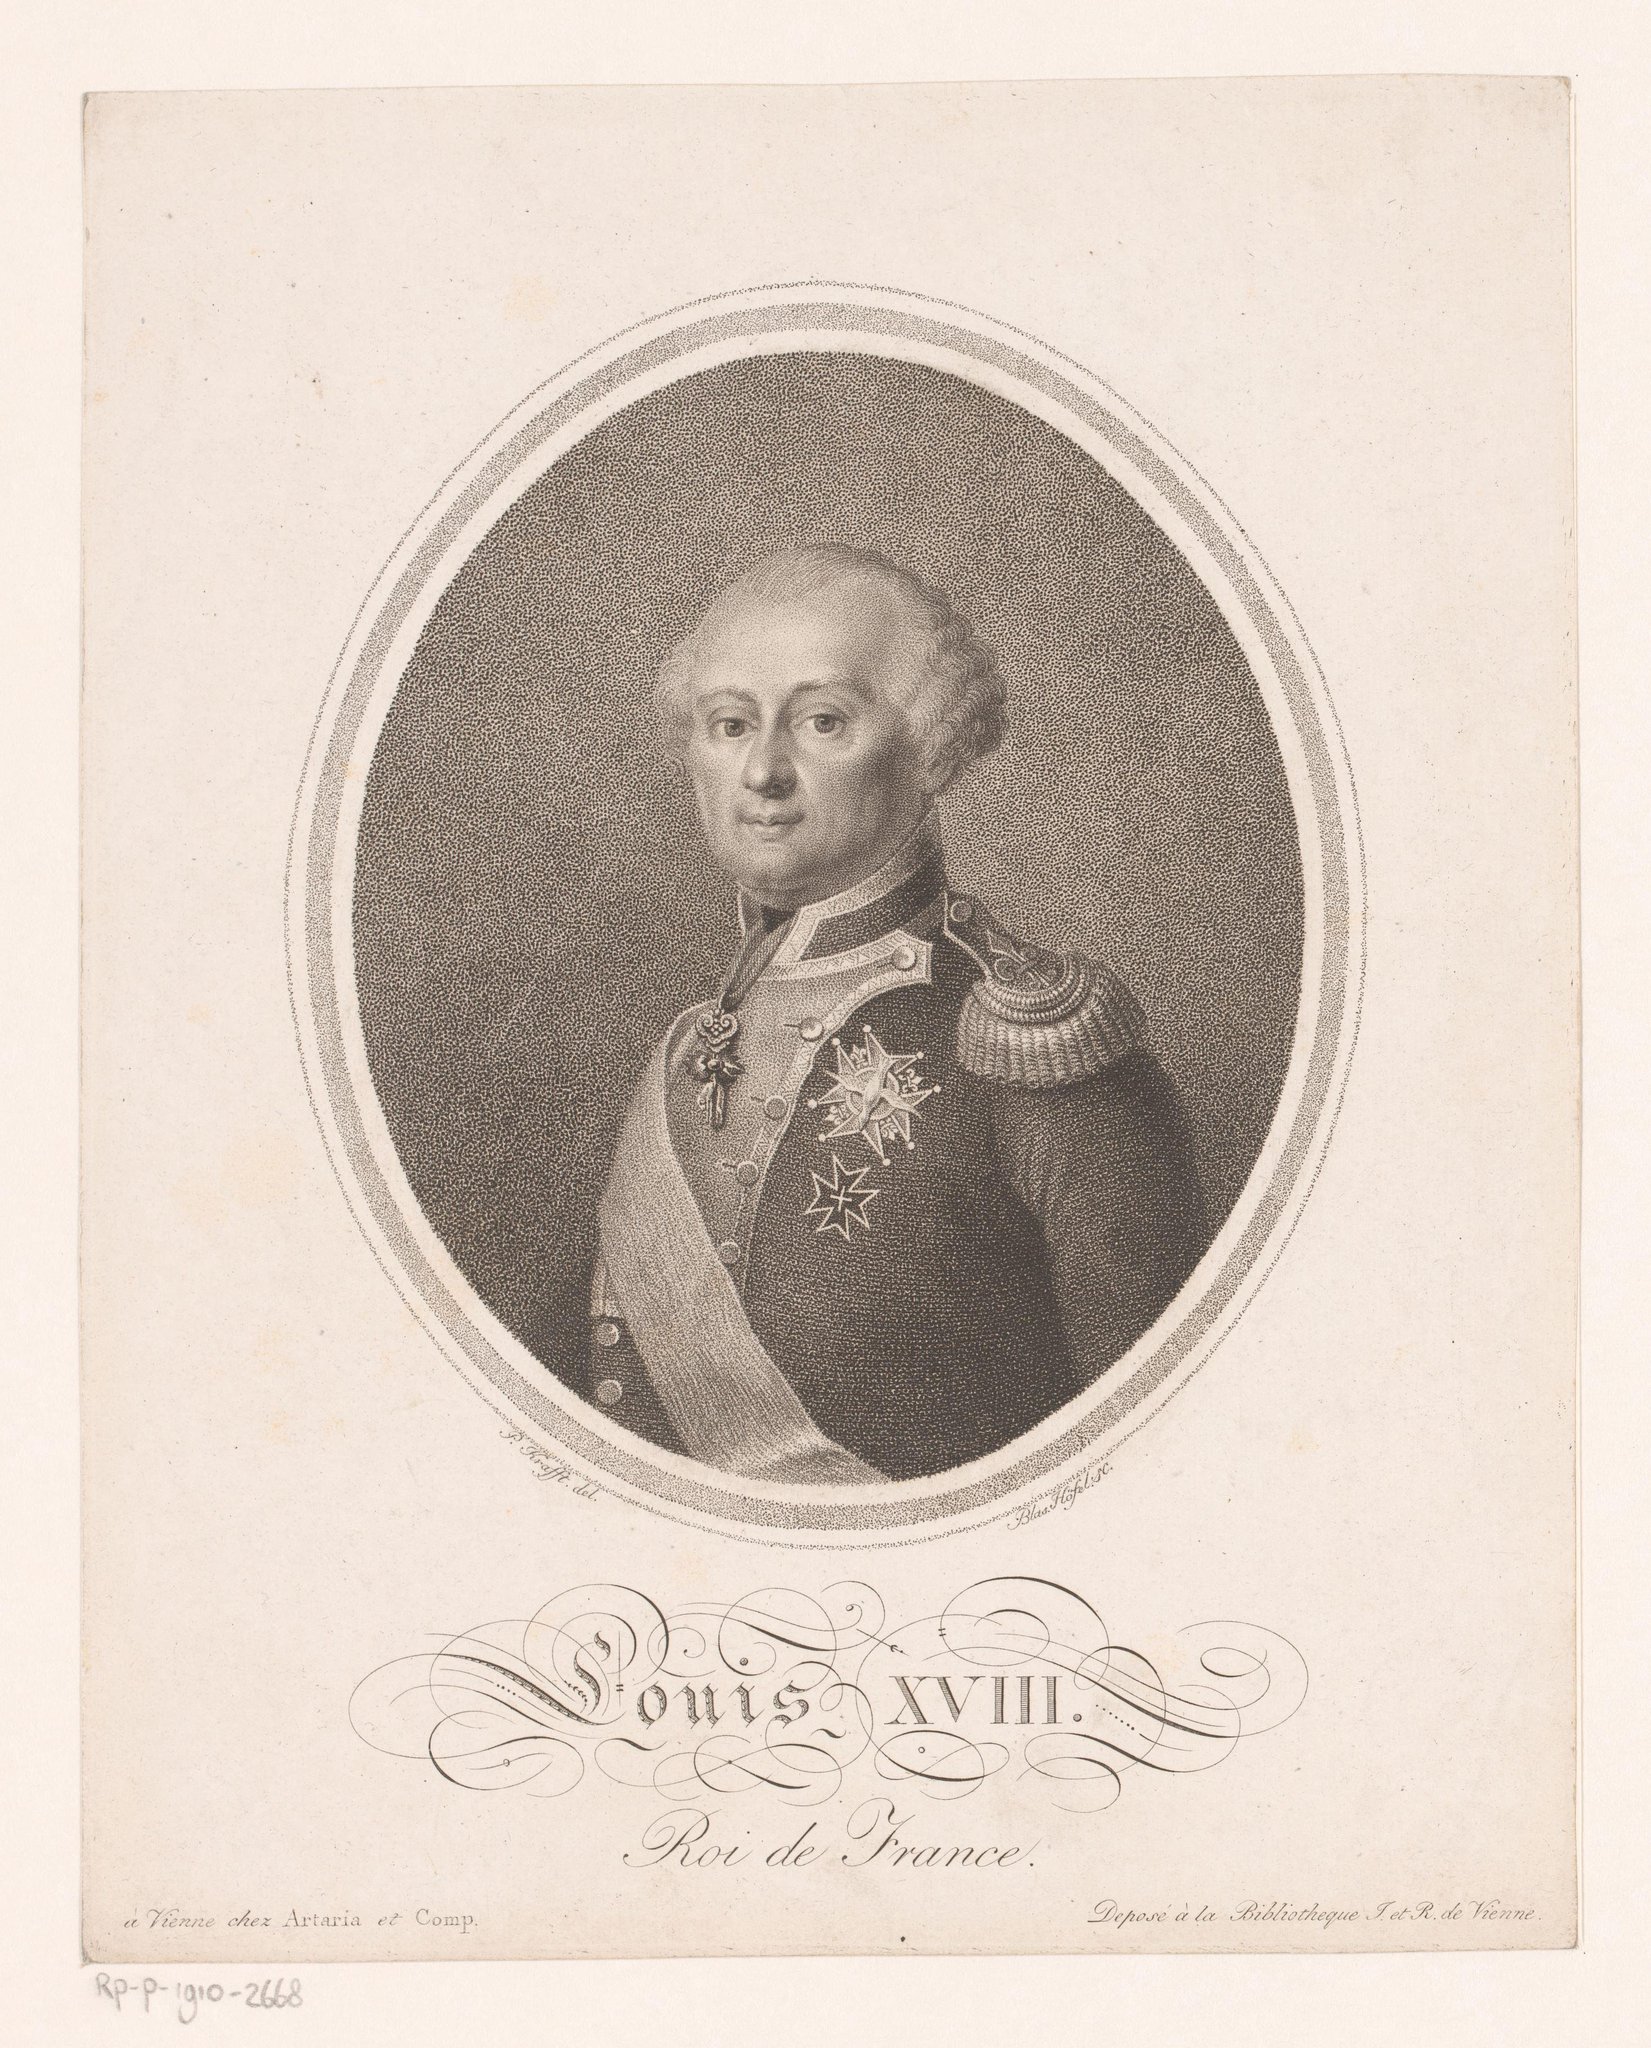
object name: print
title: Portret van Lodewijk XVIII, koning van Frankrijk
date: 1802-1824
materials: paper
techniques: stippling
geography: vienna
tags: paris, lodewijk xviii (koning van frankrijk), knighthood order, historical persons, ruler, sovereign, knighthood order of the golden fleece - insignia of a knighthood order, e.g.: badge, chain (with name of order)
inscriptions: collector's mark: Lugt 2228